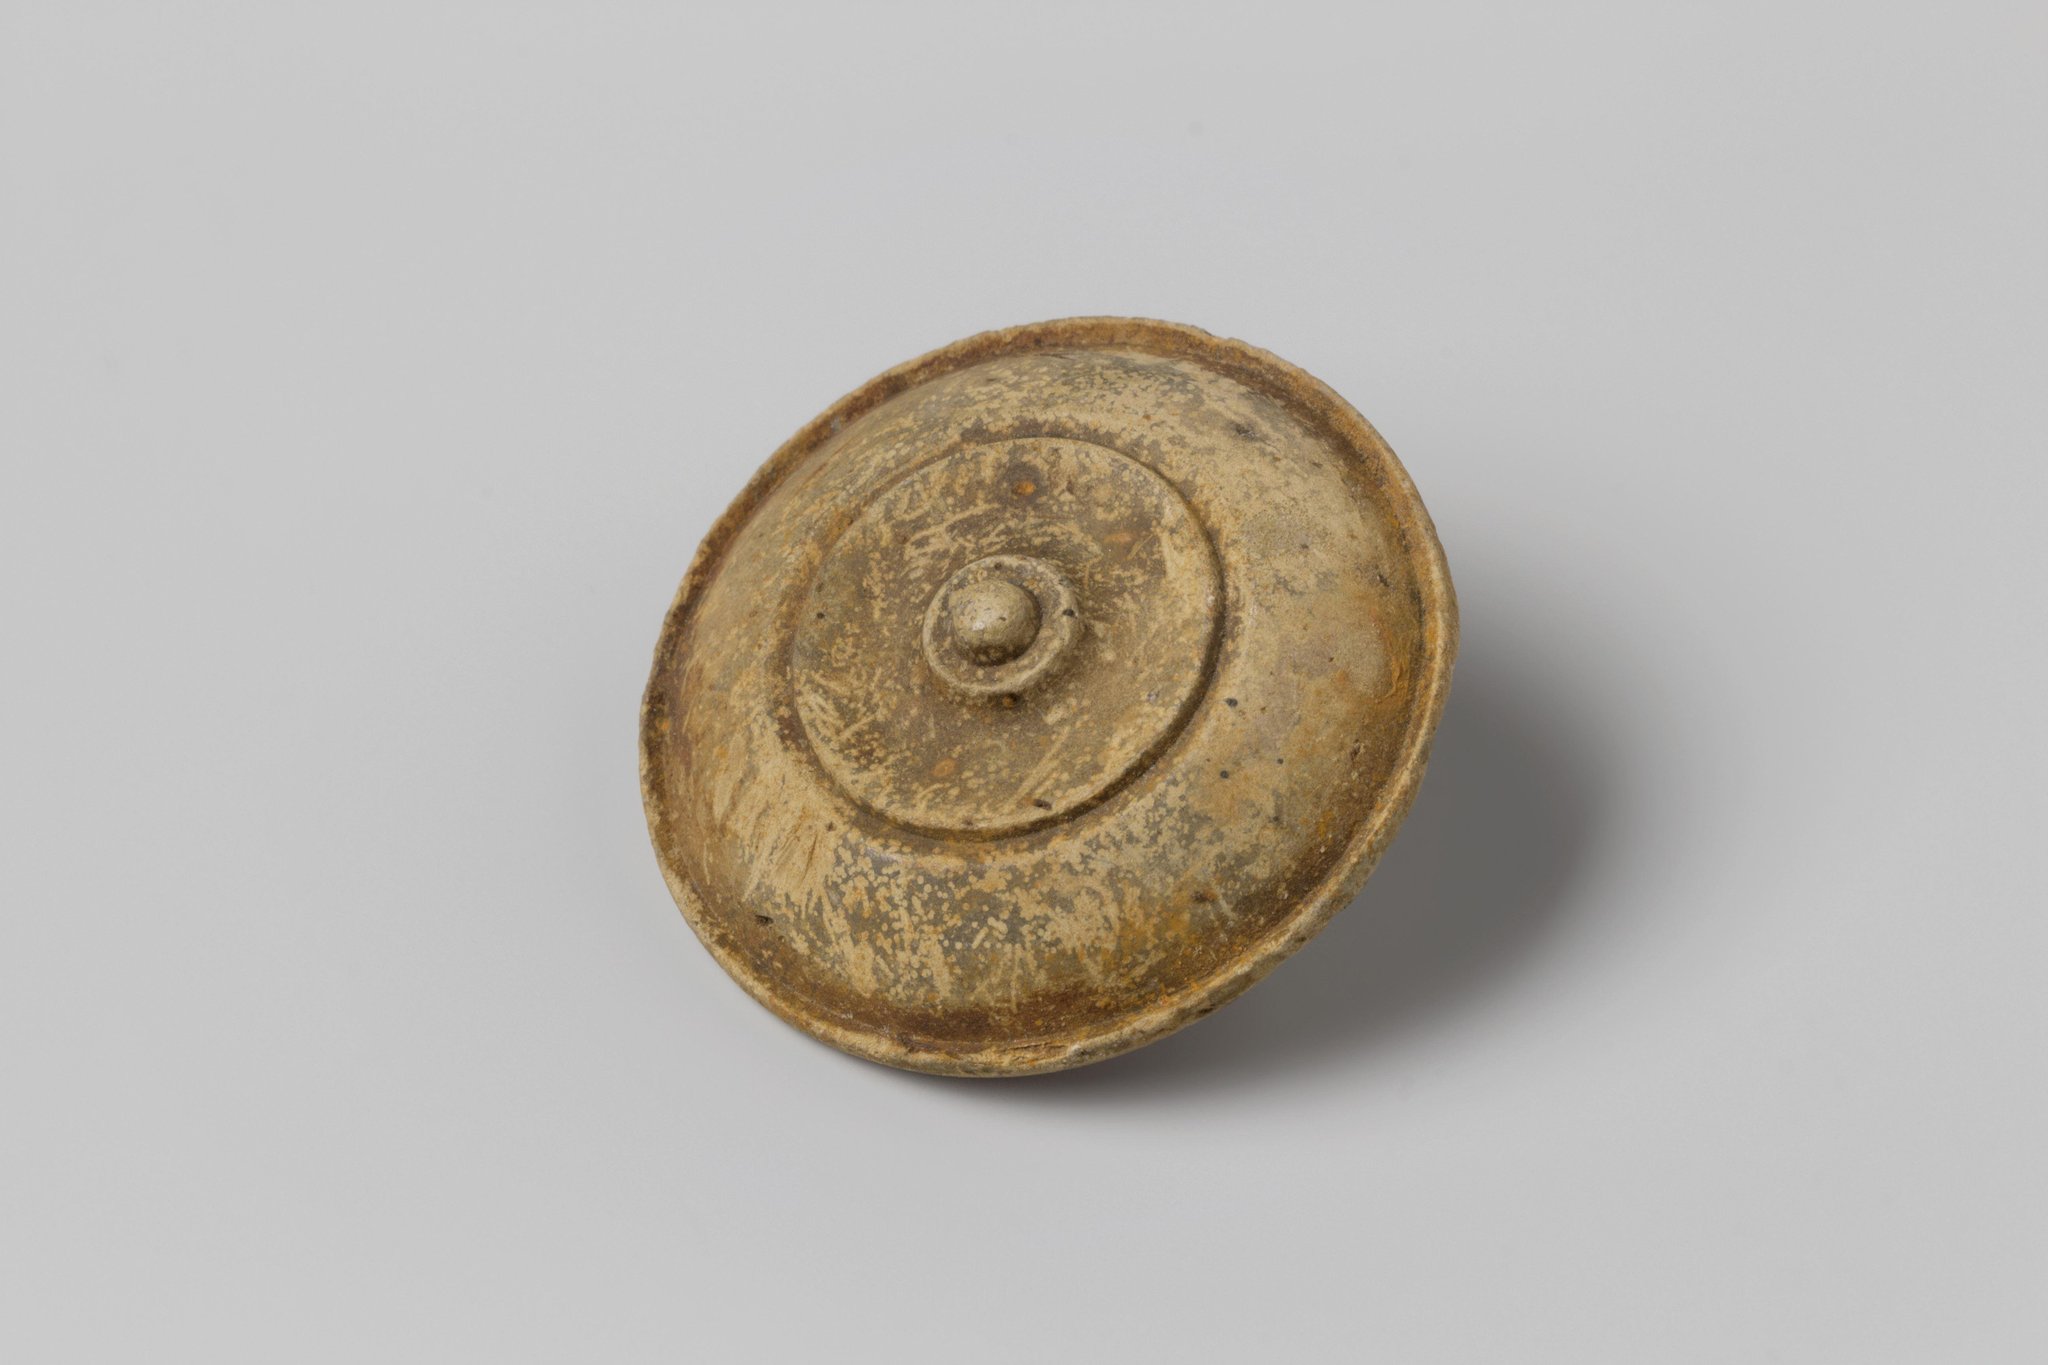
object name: button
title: Knoop uit het wrak van de Oost-Indiëvaarder Hollandia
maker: Anonymous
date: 1700-1743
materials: bone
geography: netherlands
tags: verenigde oostindische compagnie, hollandia (schip), annet